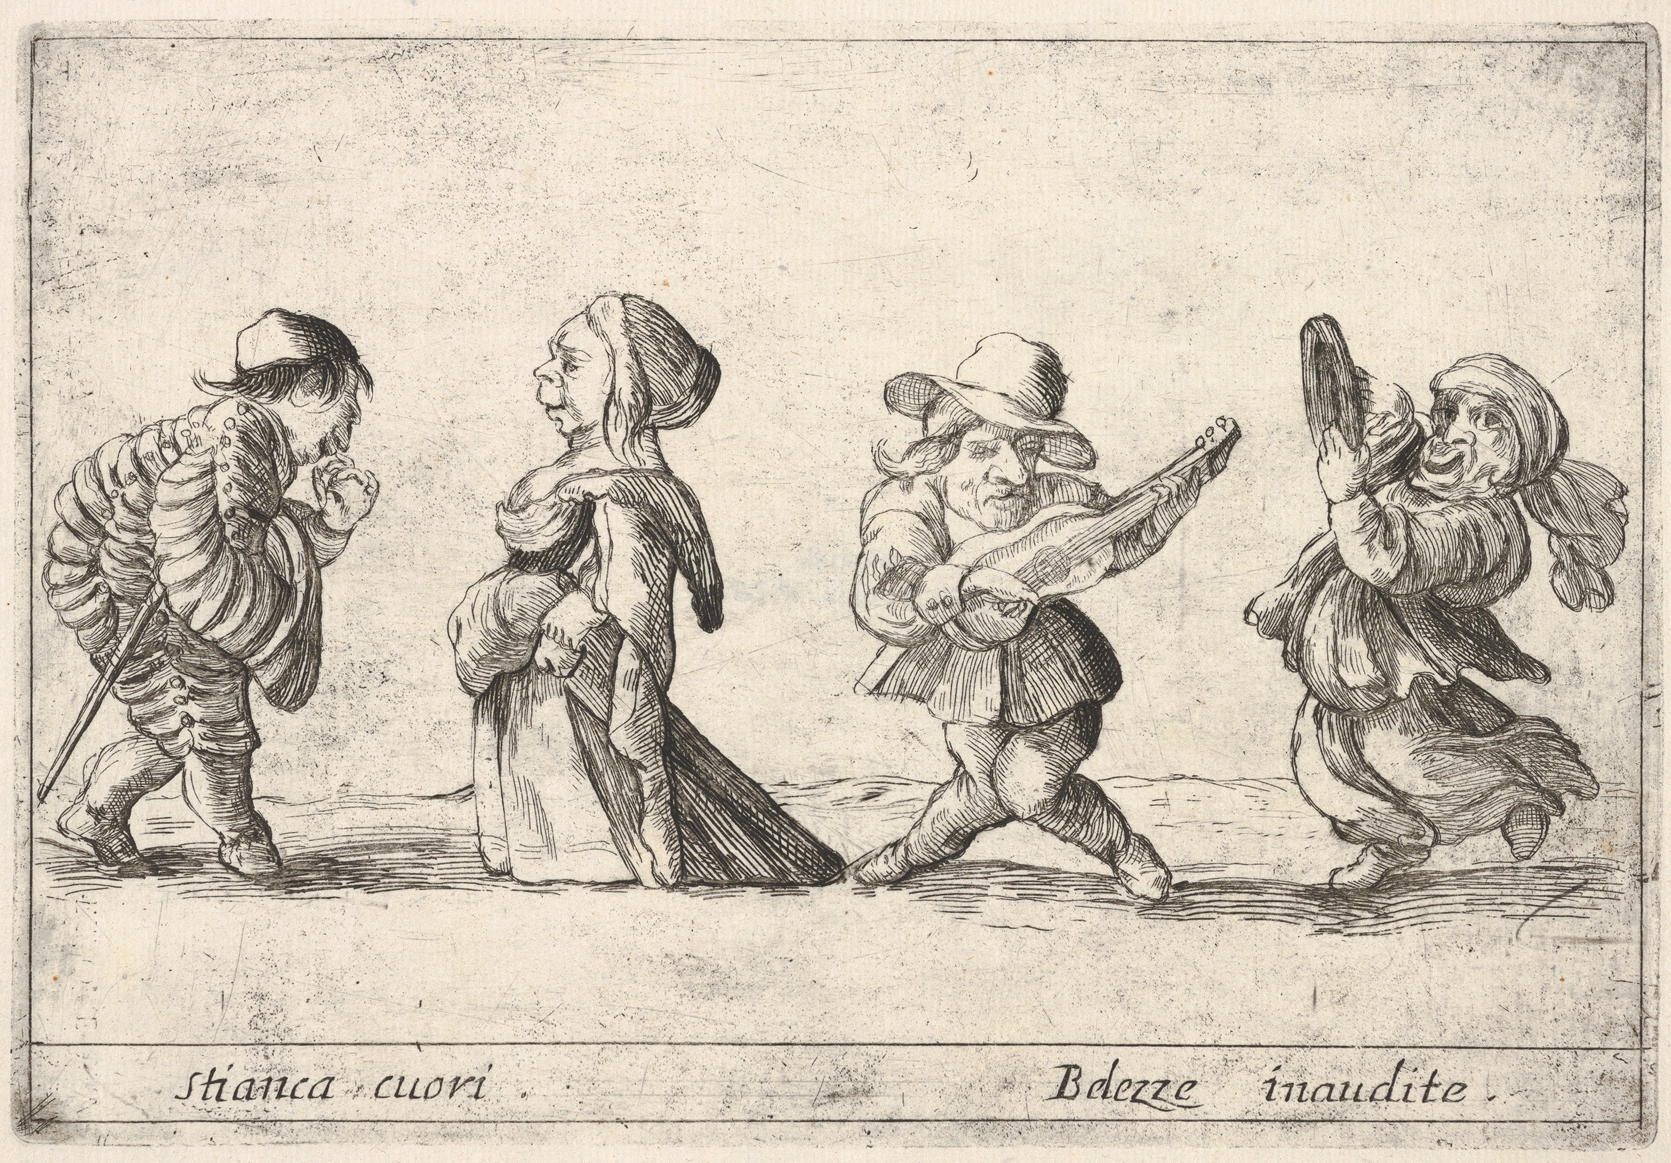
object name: print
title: Callot figures; a well-dressed dwarf man to left declaring his love to an old dwarf woman to left, a dwarf man playing the guitar and a dwarf woman dancing with a tambourine to right, from Six grotesques (Six pièces de figures grotesques)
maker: agostino mitelli ii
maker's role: artist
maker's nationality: italian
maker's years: 1671-1696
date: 1684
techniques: etching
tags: men,women,dancing,guitars